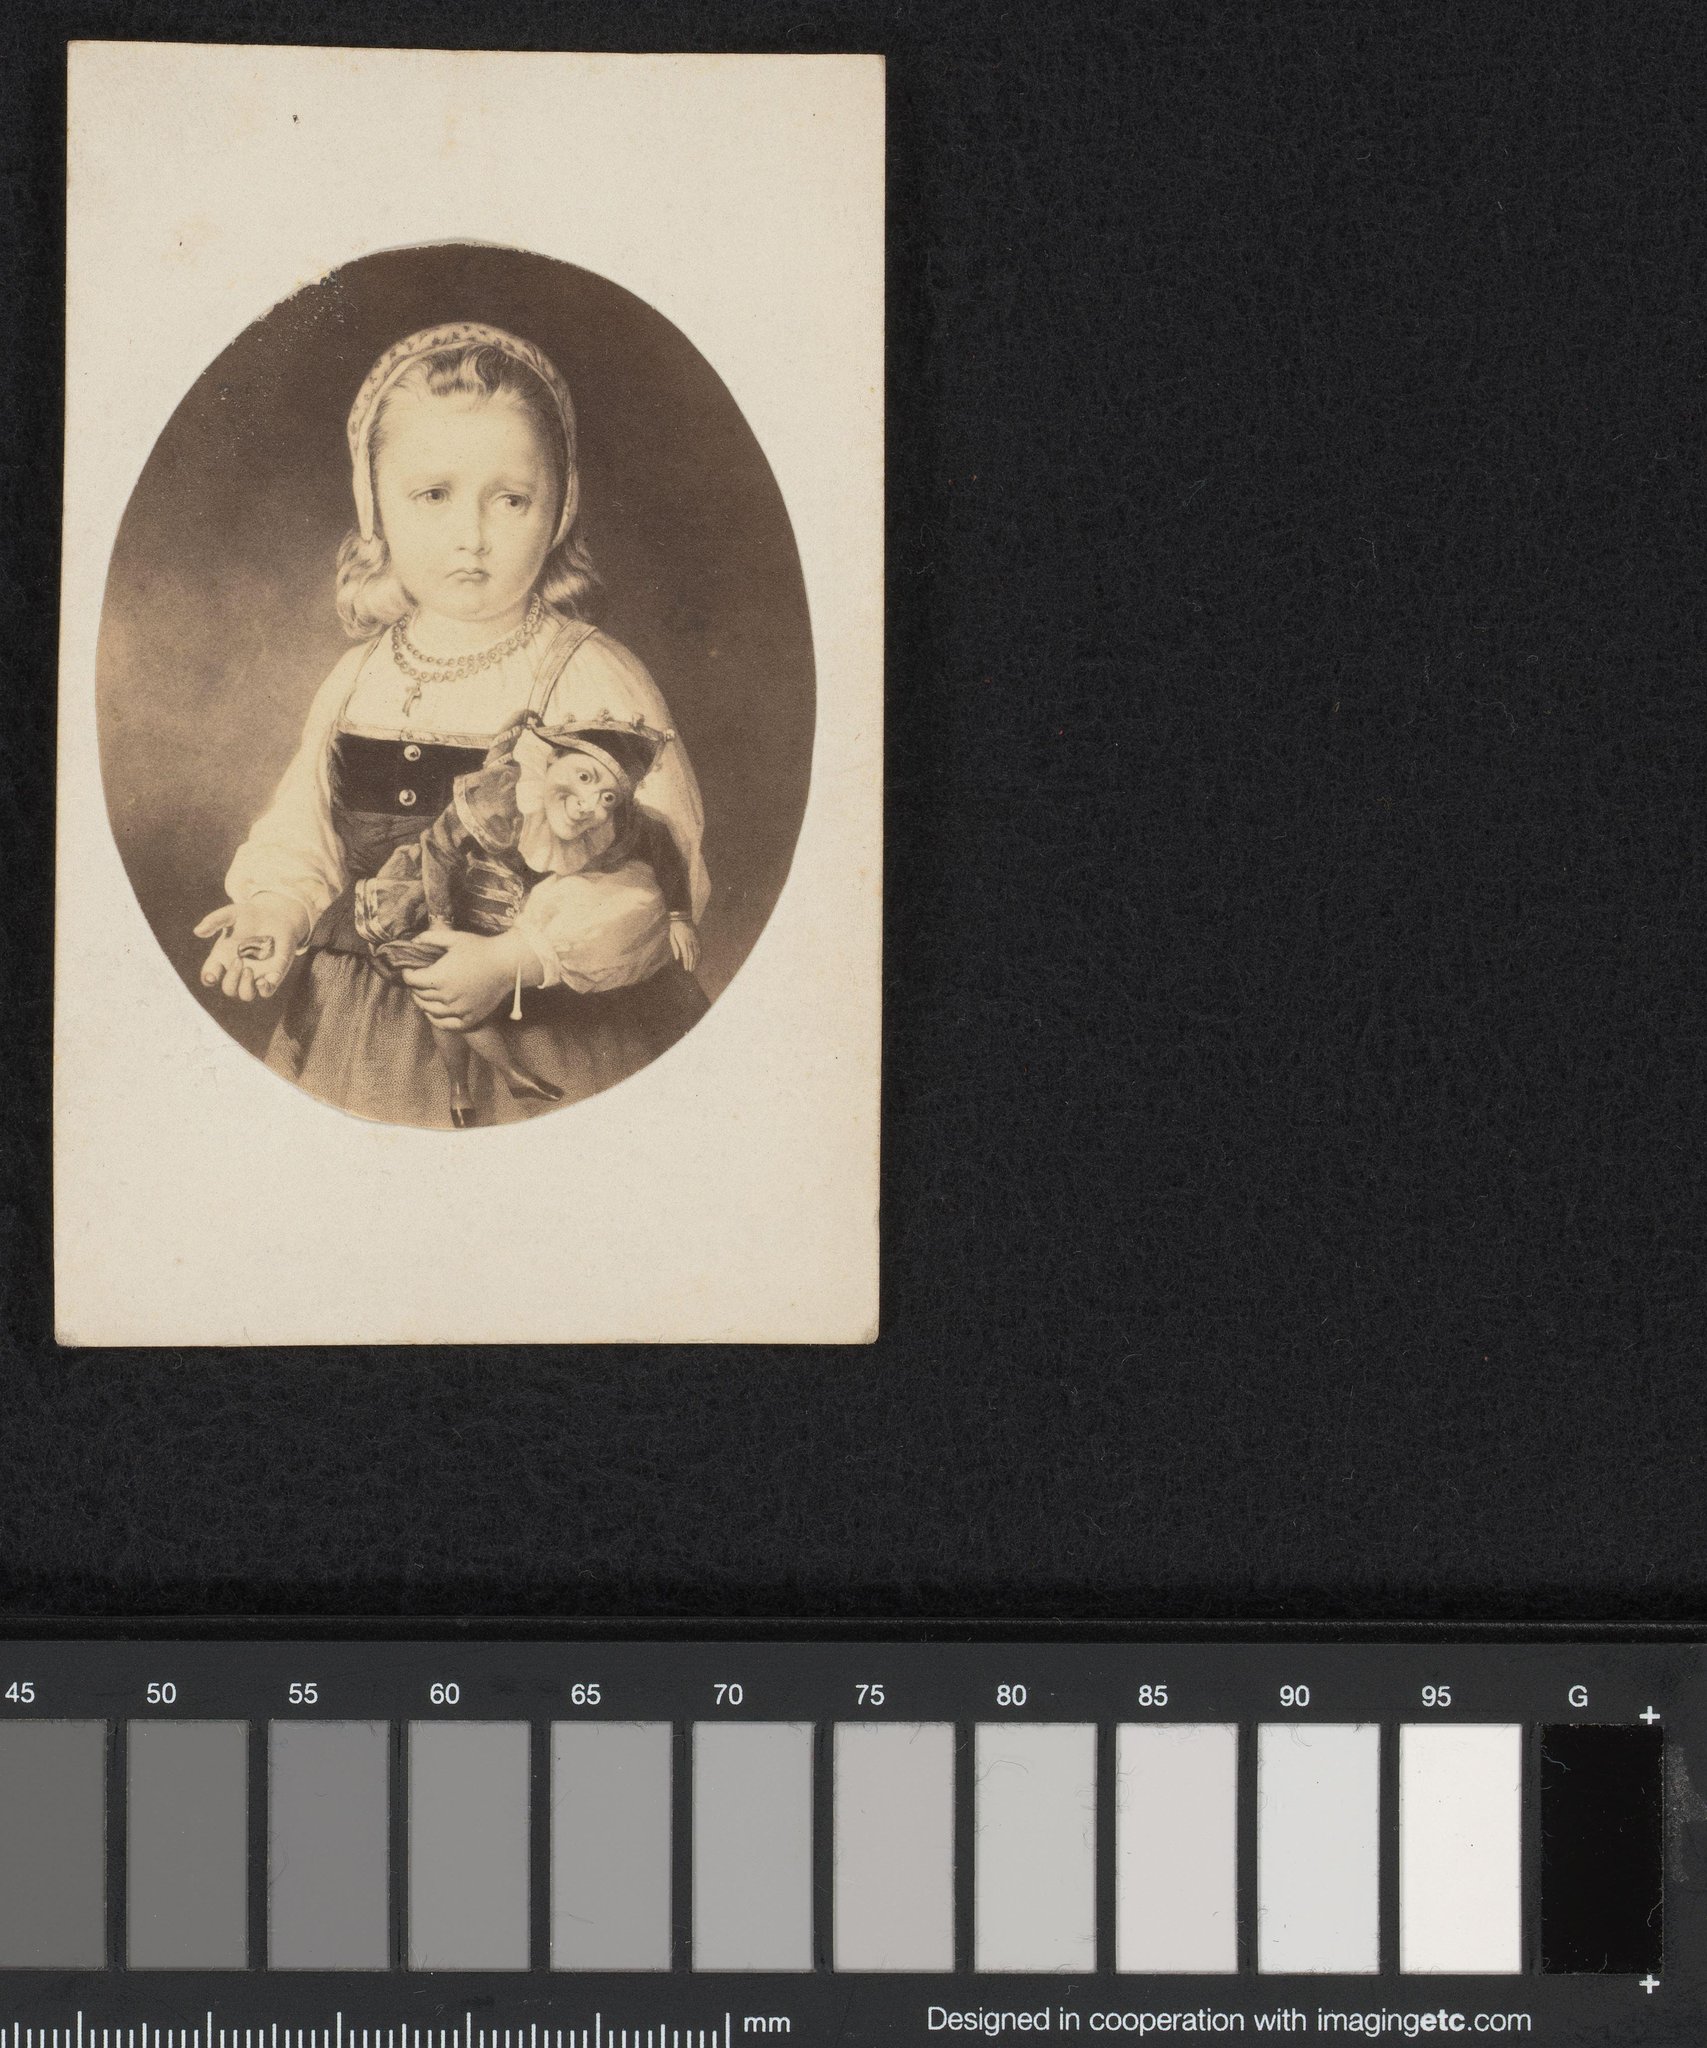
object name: reproduction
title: Fotoreproductie van een schilderij met pruilend meisje met narrenpop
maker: Anonymous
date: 1860-1900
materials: cardboard, photographic support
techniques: albumen print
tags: girl (child between toddler and youth), (playing with) dolls